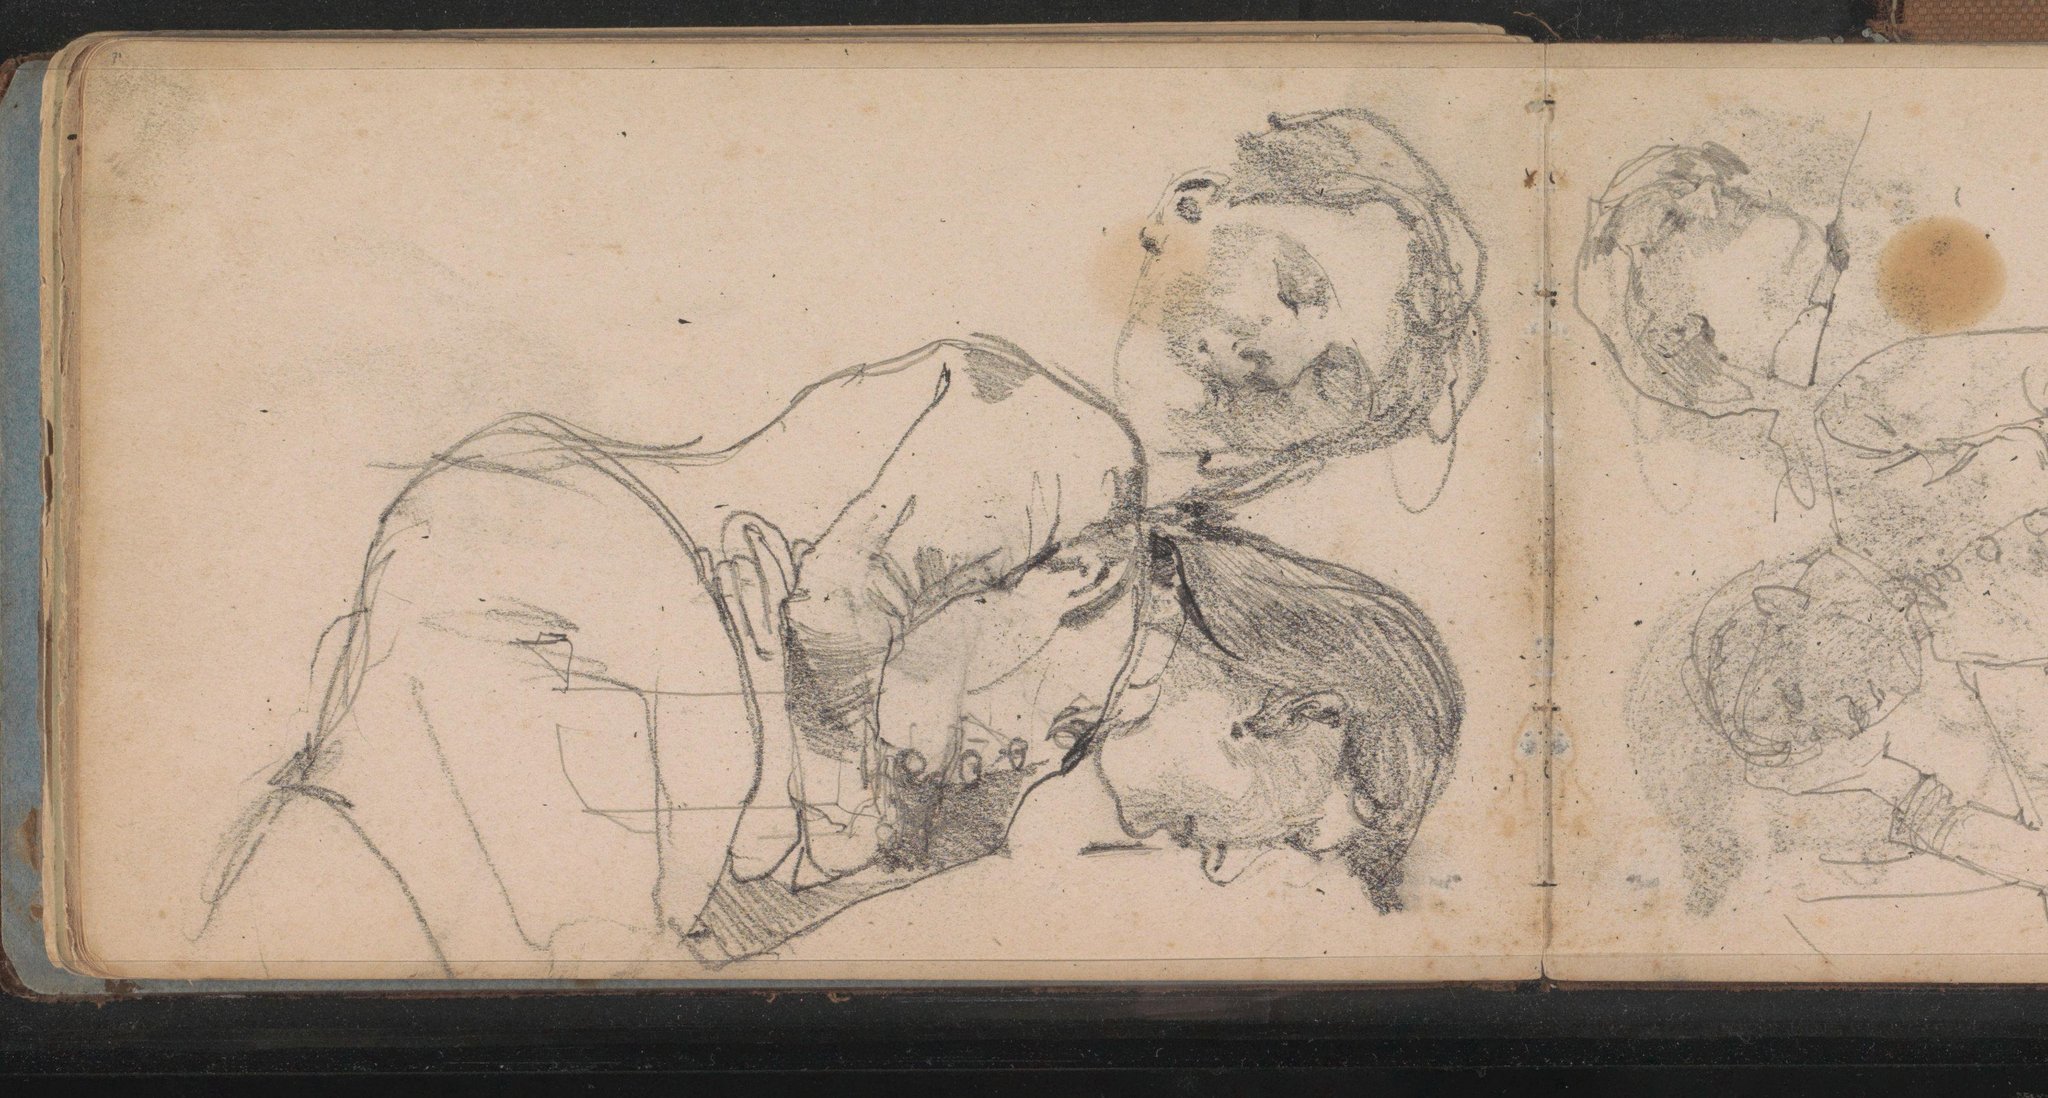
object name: sketchbook leaf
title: Twee figuurstudies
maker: george hendrik breitner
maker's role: draughtsman, painter, print maker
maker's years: 1857-1923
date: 1880-1882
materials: paper, pencil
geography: scheveningen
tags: head (human), adult woman, mind, spirit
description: De figuren slapen mogelijk. Pagina 71 uit een schetsboek met 37 bladen.